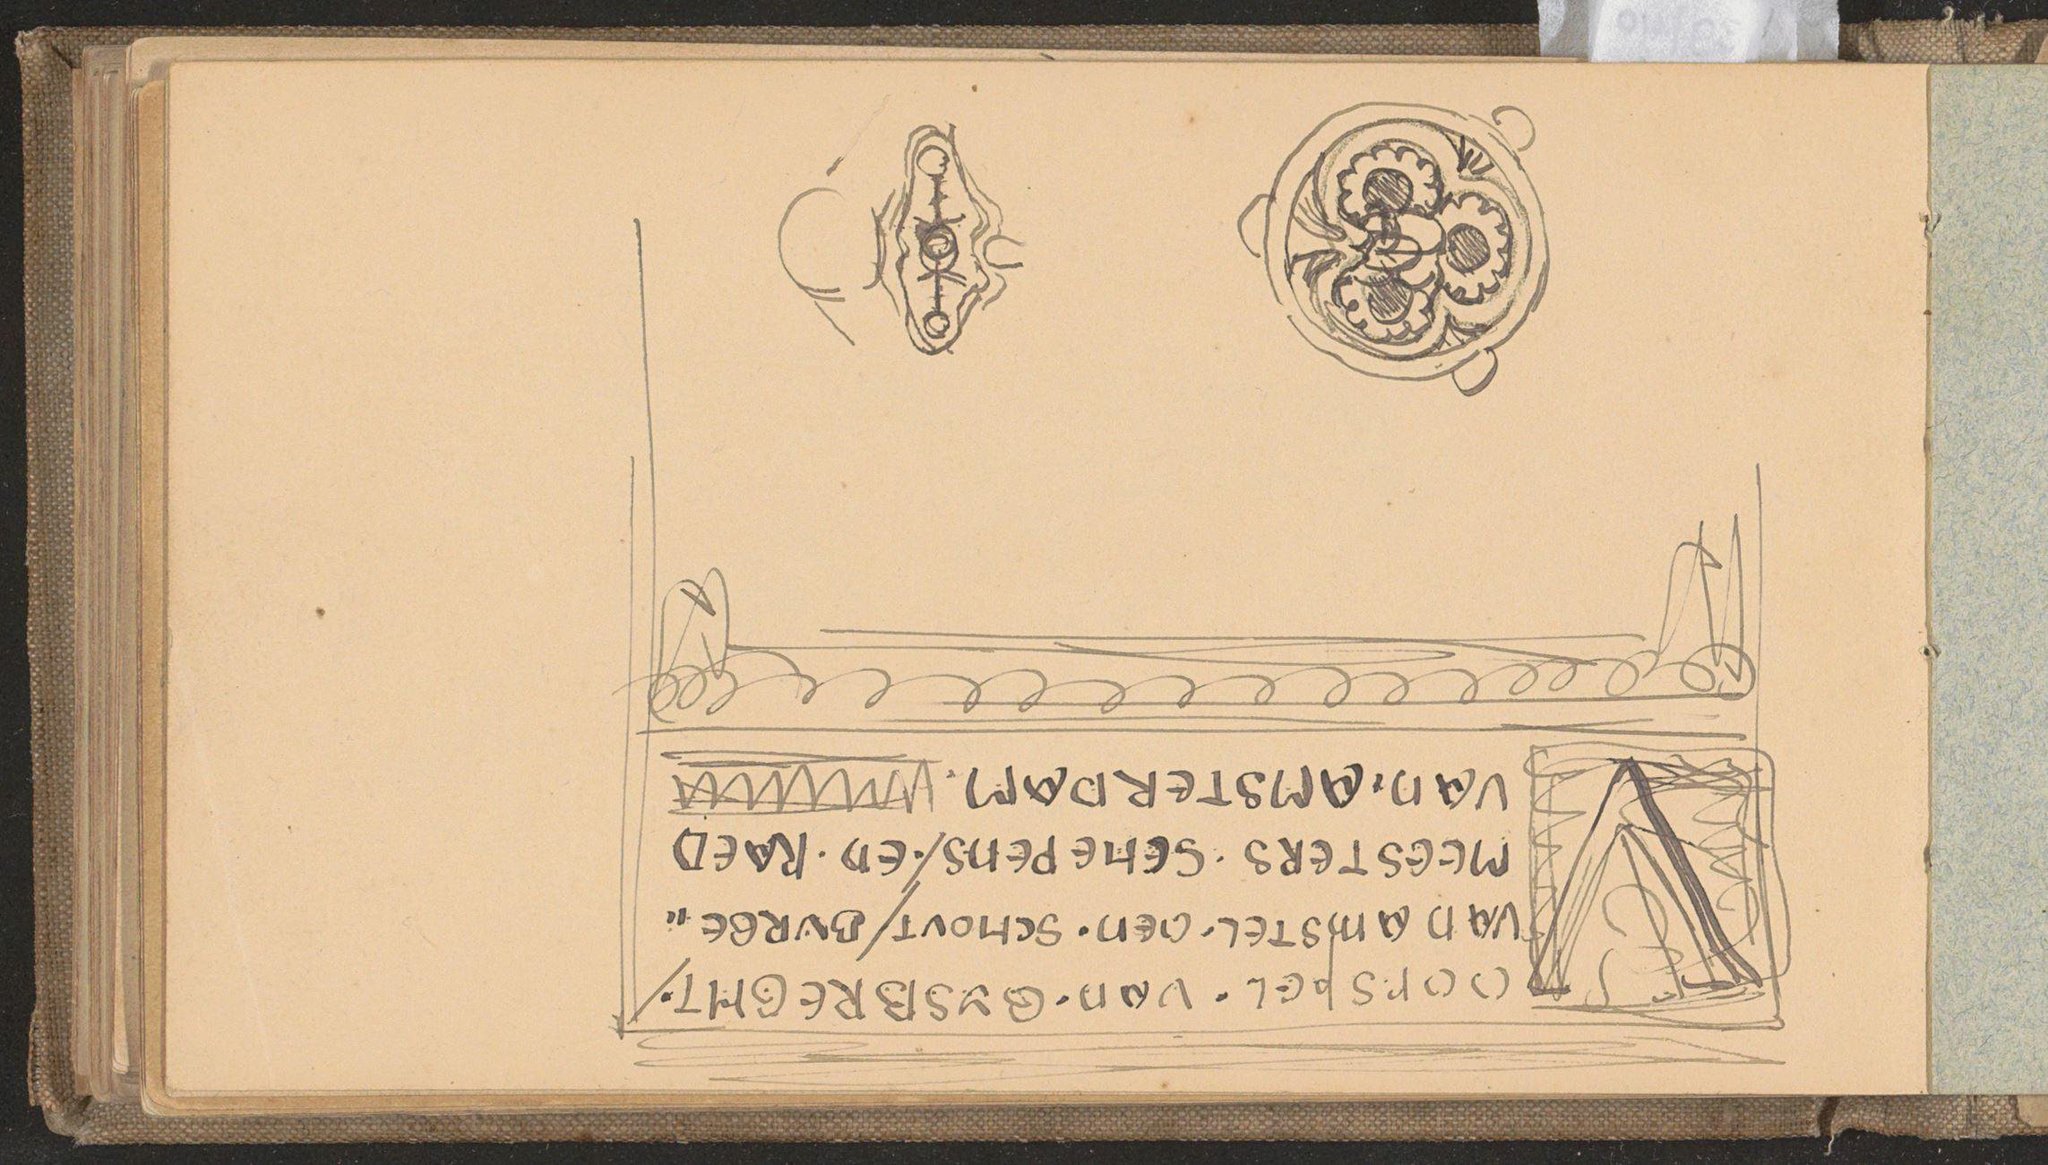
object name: sketchbook leaf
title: Boekontwerp voor: 'Gijsbrecht van Aemstel' van Joost van den Vondel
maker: antoon derkinderen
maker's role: draughtsman, painter, print maker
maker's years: 1859-1925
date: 1893-1901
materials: ink, paper, pencil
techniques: pen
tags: decoration of printed matter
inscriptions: annotation: ‘Voorspel.van.gysbreght./ van amstel. aen.schout.burg/ meesters.schepens/.en.raed/ van.Amsterdam.’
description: Ontwerp voor een versierde pagina met het Voorspel. Blad 44 verso uit een schetsboek met 51 bladen.